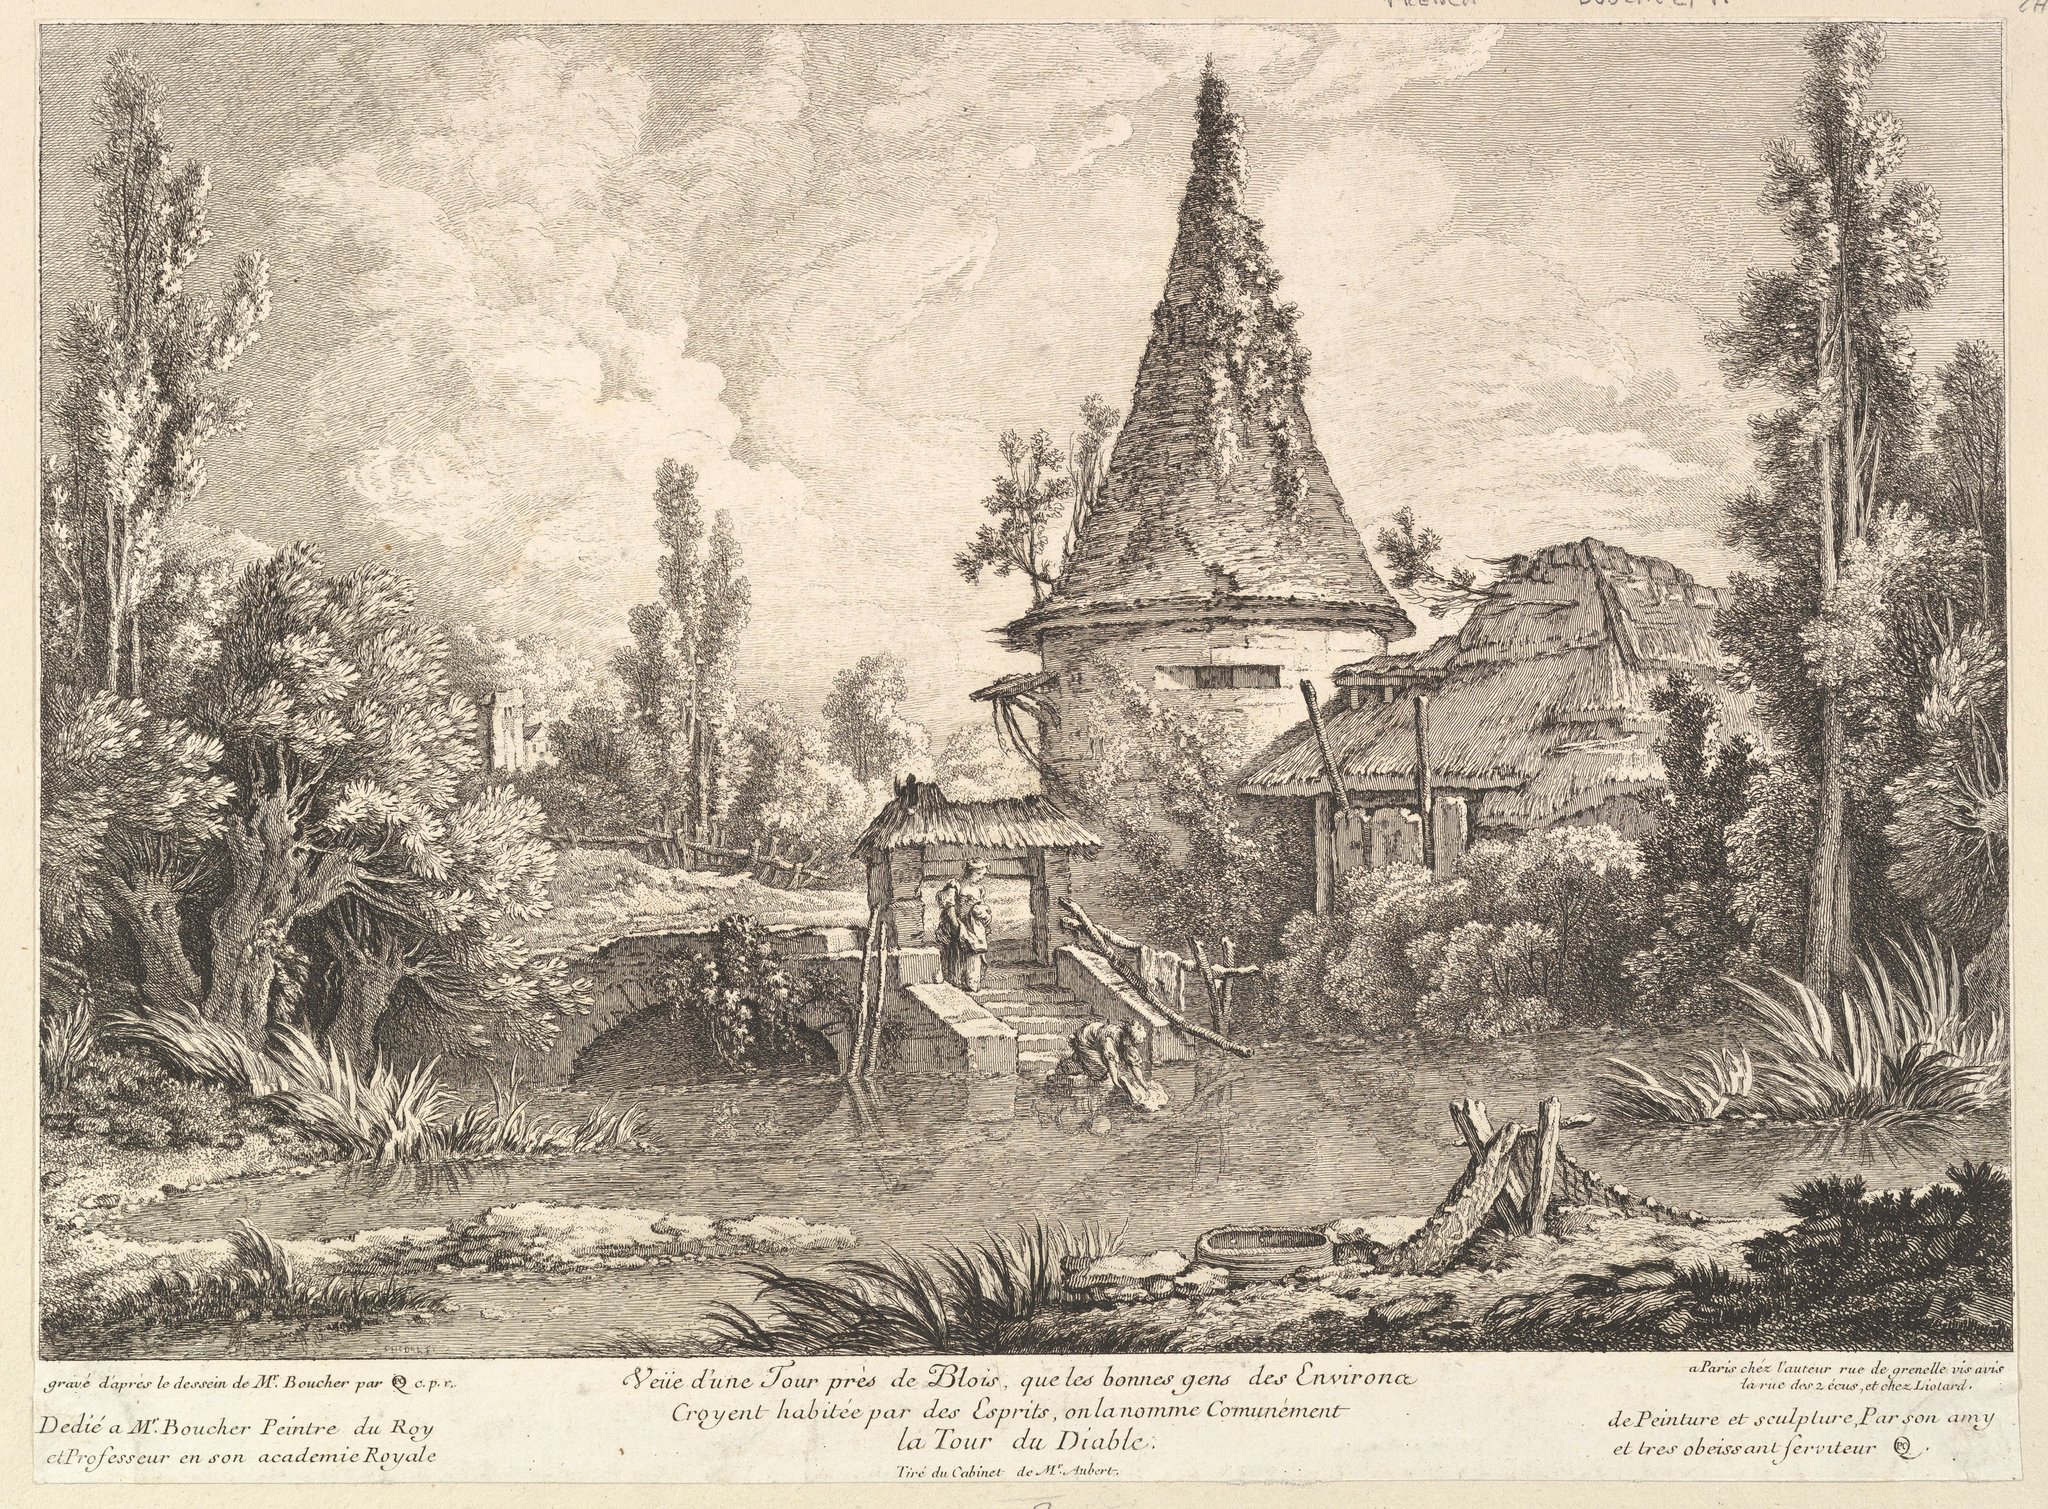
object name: print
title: View of Tower near Blois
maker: quentin pierre chedel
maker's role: artist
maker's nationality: french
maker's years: 1705-1763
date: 1734-1766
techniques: etching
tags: towers,landscapes